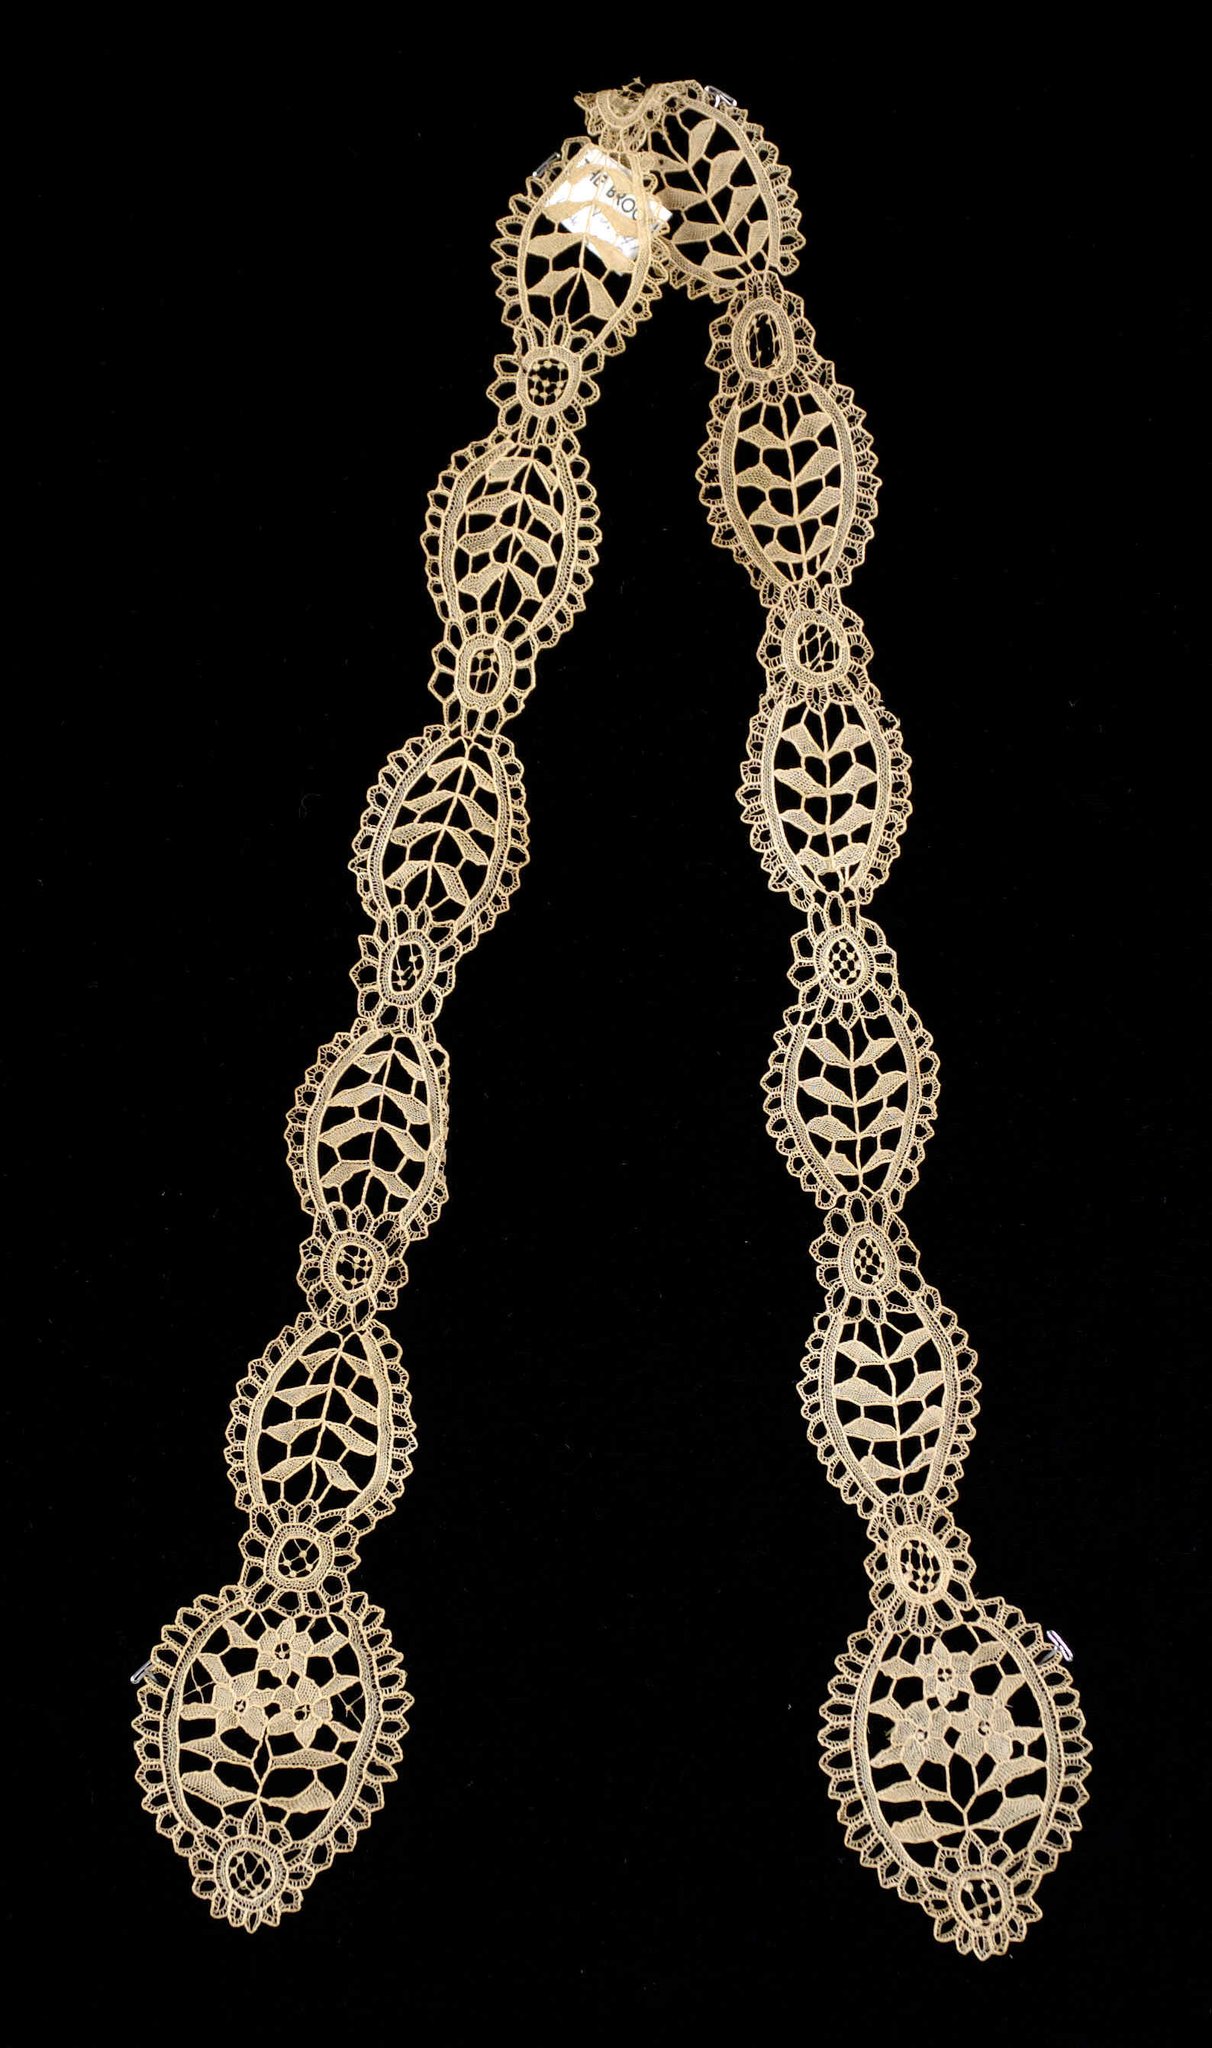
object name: lappet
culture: american or european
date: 1834-1866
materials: linen